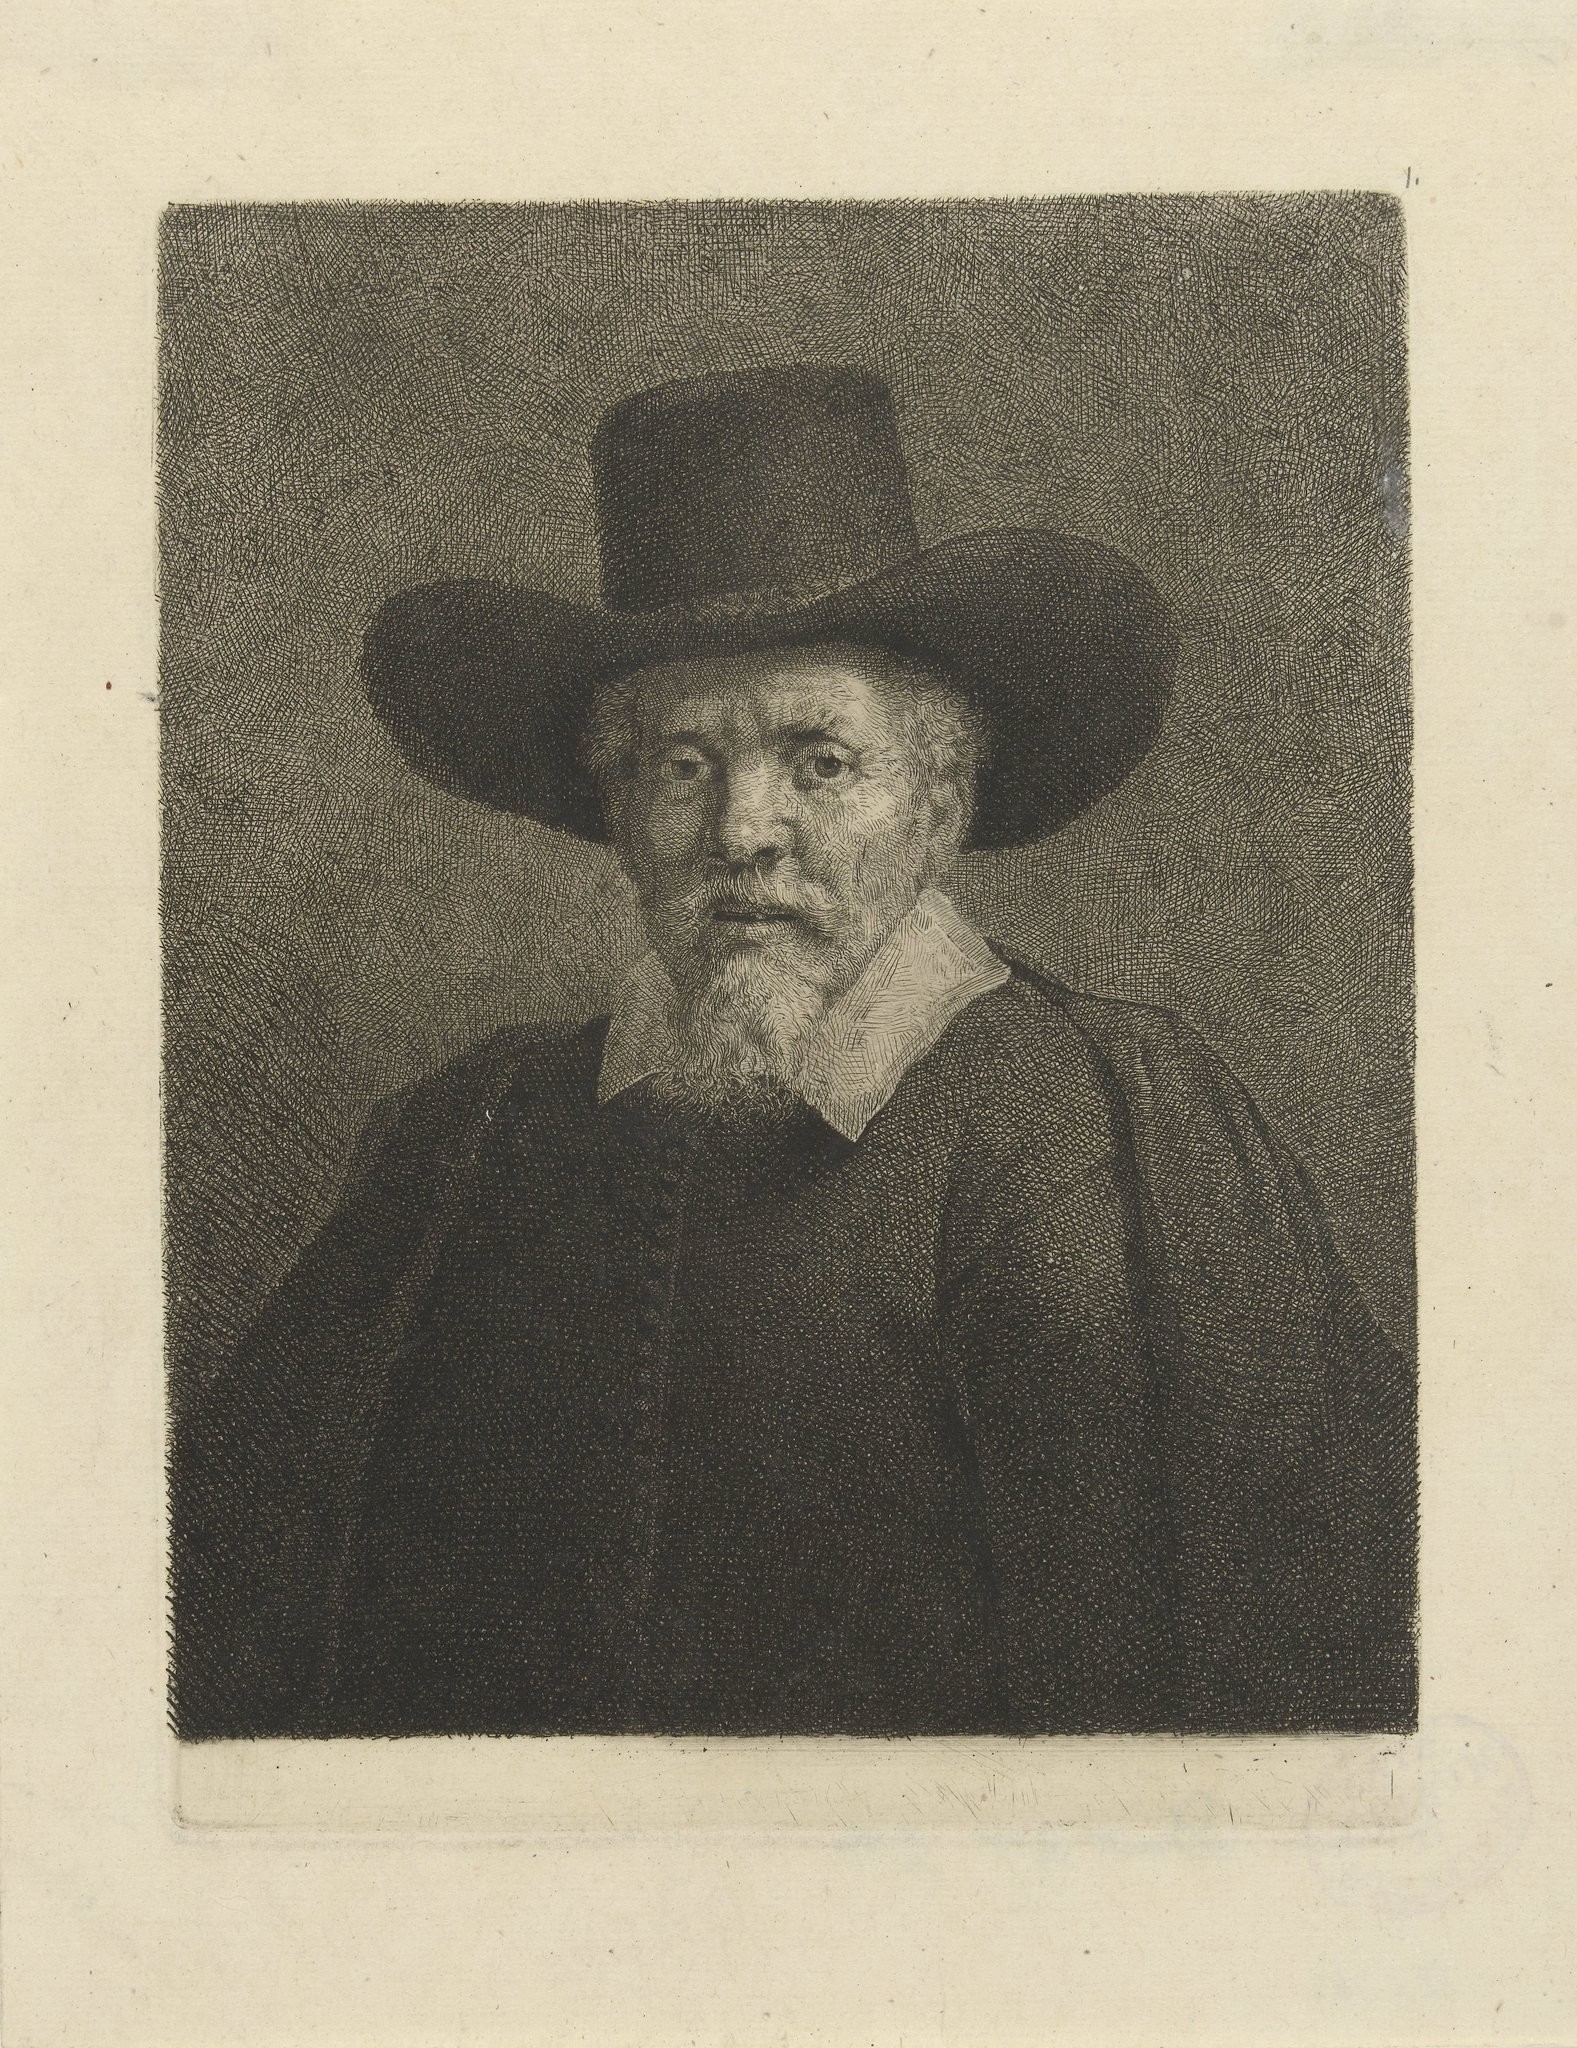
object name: print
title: Portret van Arnout Tholinx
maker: johannes pieter de frey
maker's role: draughtsman, print maker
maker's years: 1770-1834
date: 1797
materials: paper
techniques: etching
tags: physician, doctor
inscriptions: number: ‘1’, collector's mark: Lugt 12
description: Prent naar schilderij van Rembrandt van Rijn, aanwezig in de collectie van Musée Jacquemart-André te Parijs.